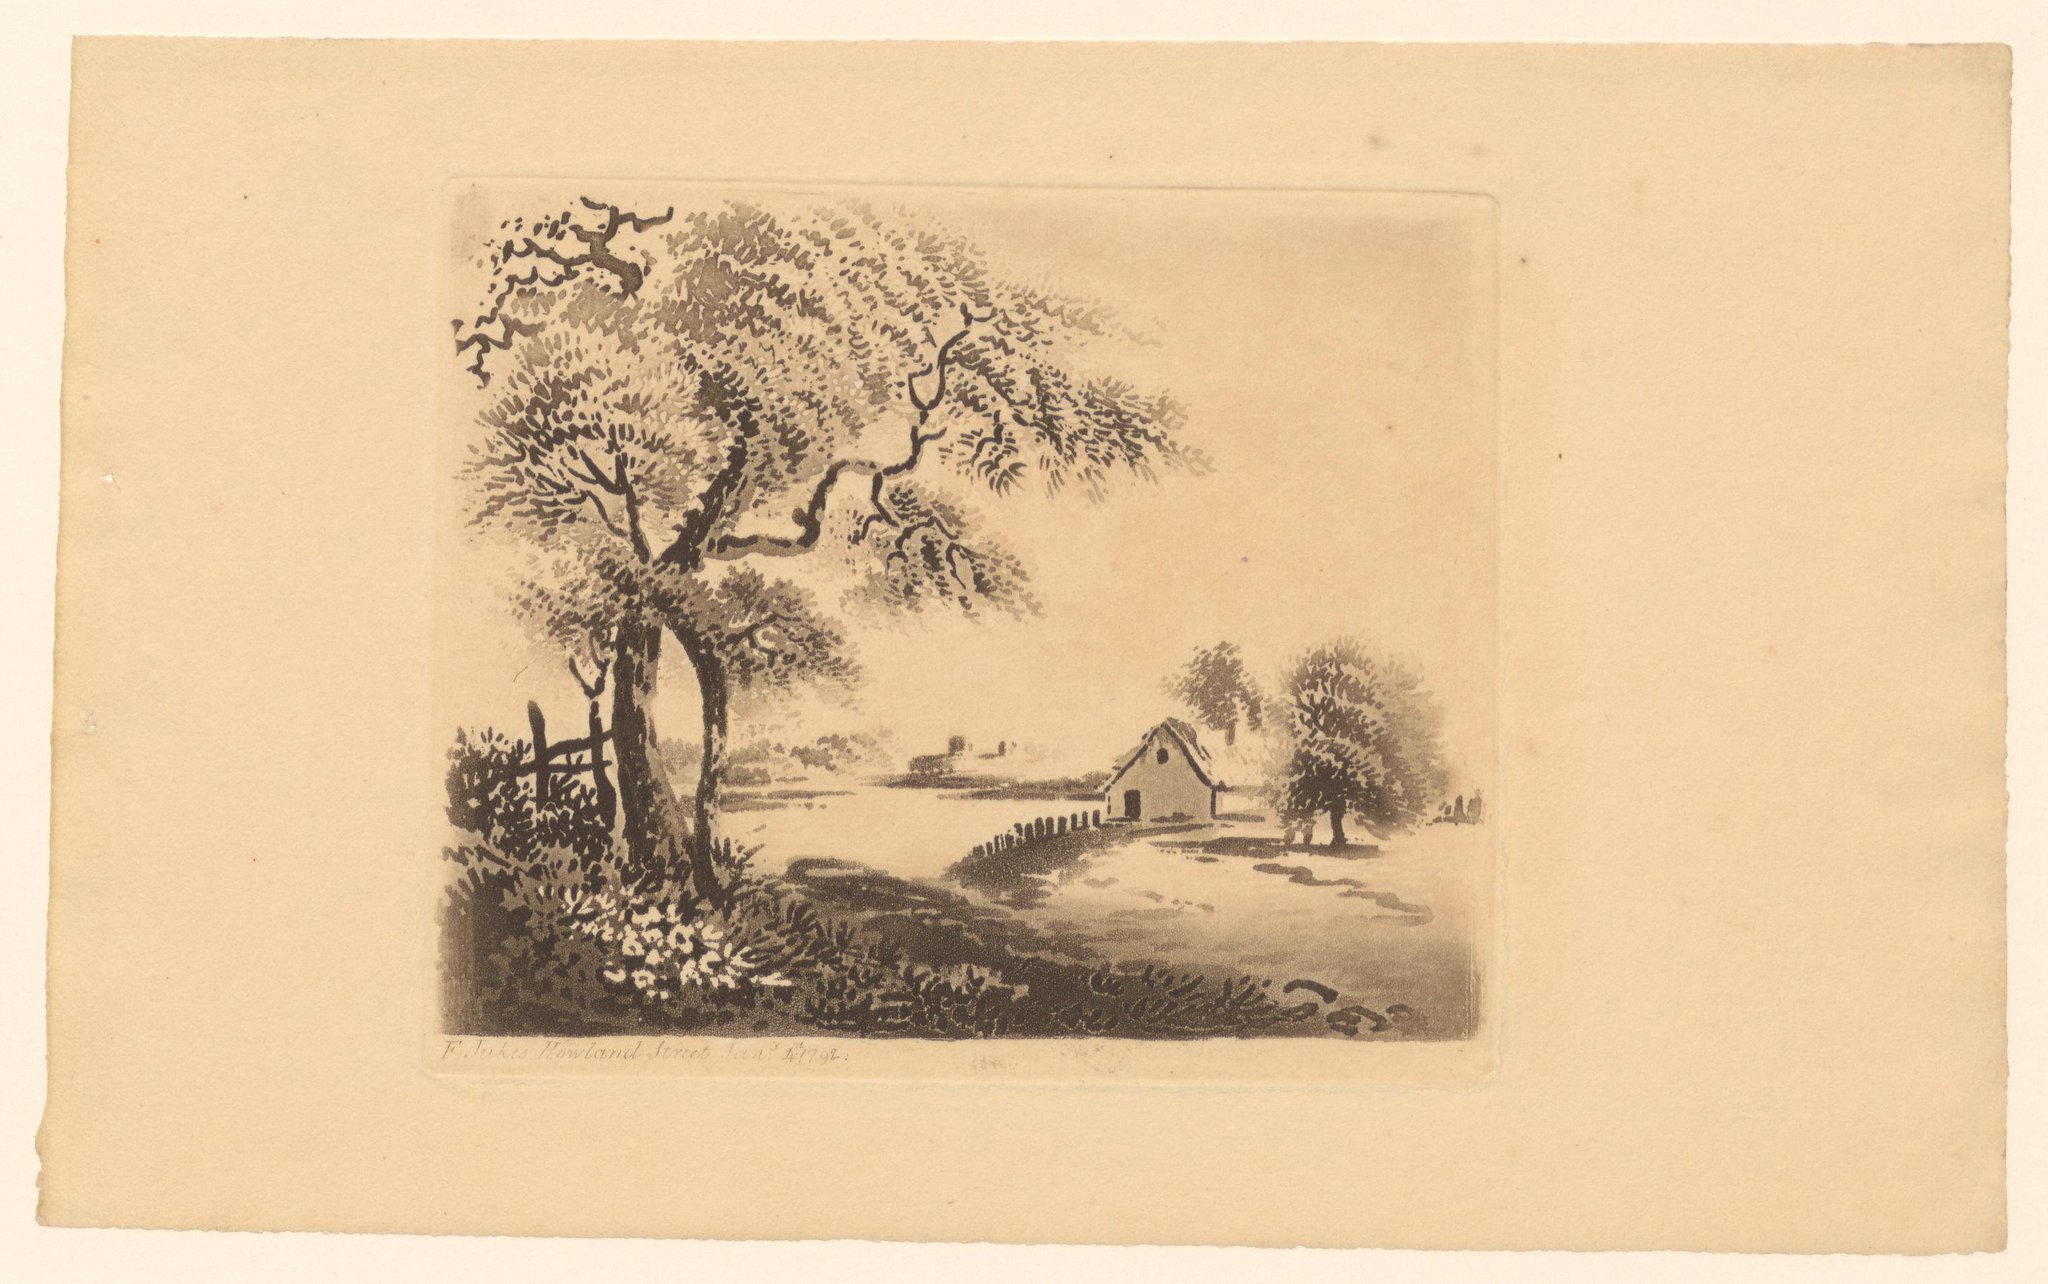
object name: print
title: Landschap met bomen bij een huis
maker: francis jukes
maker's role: print maker, publisher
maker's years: 1745-1812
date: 1755-1812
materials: paper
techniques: aquatint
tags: farm or solitary house in landscape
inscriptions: collector's mark: Lugt 2228